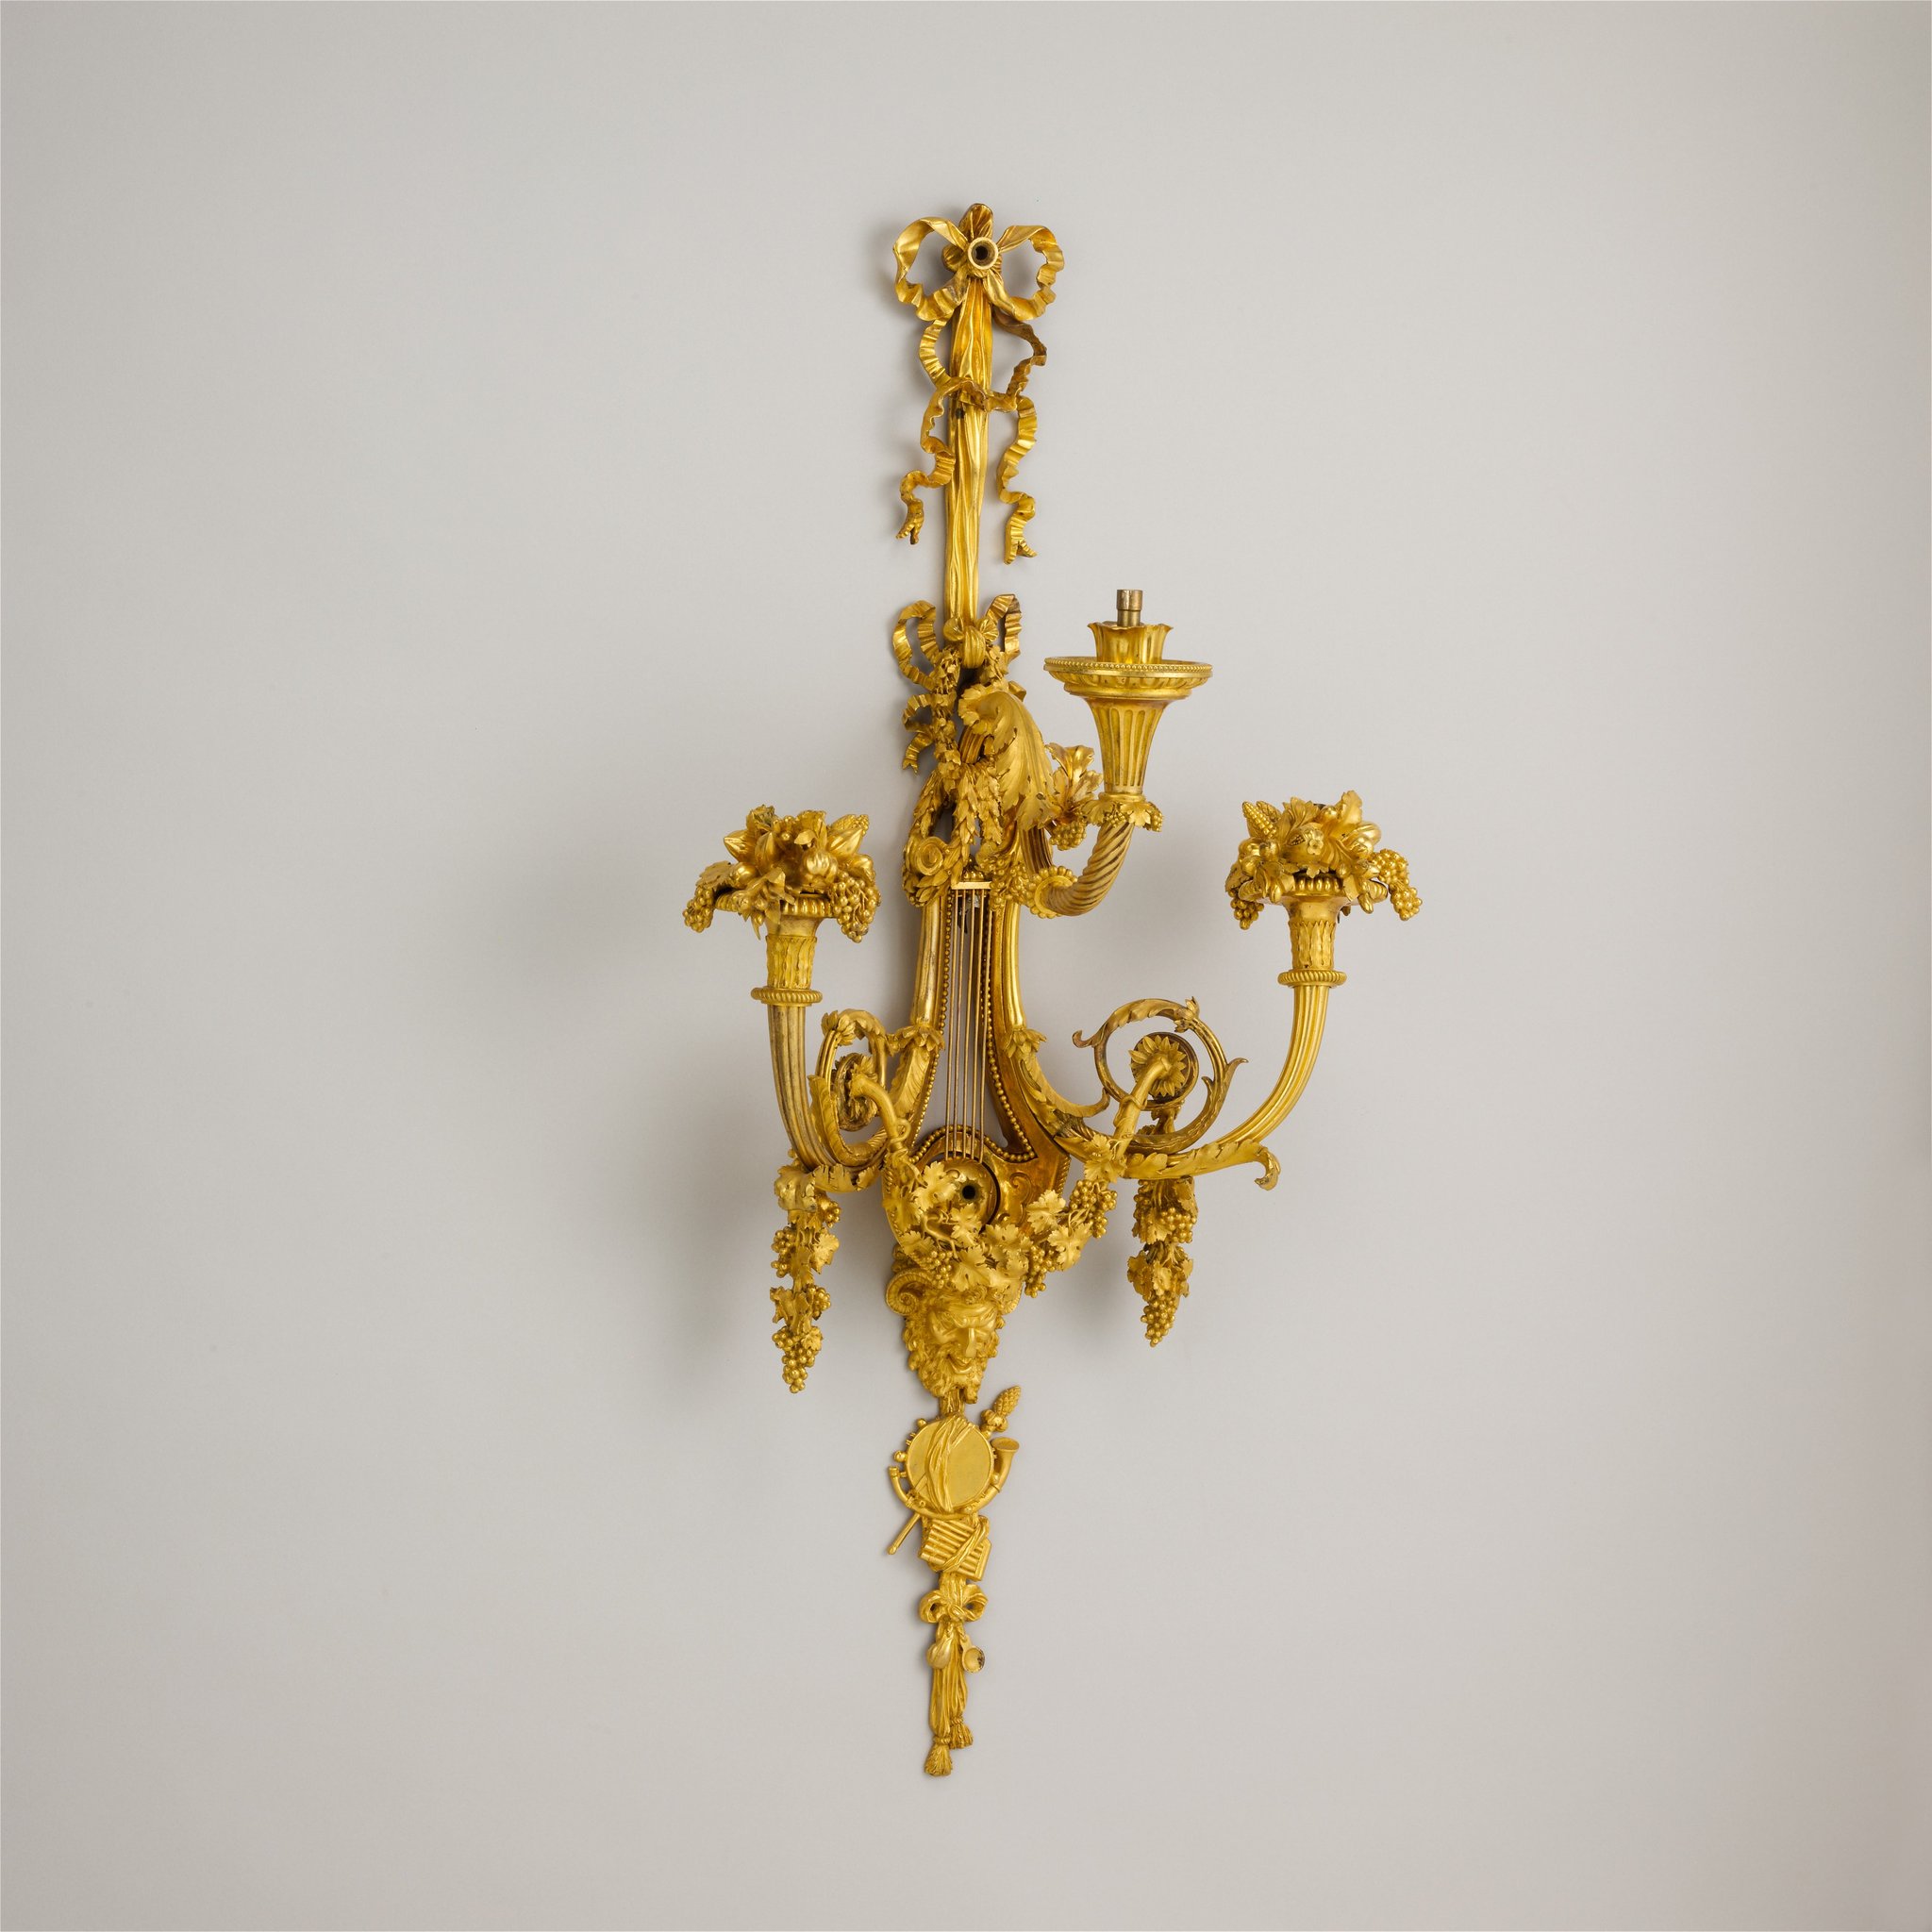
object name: sconce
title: Set of four three-light sconces (bras de lumière)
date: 1787-1788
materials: gilt bronze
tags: grapes,satyrs